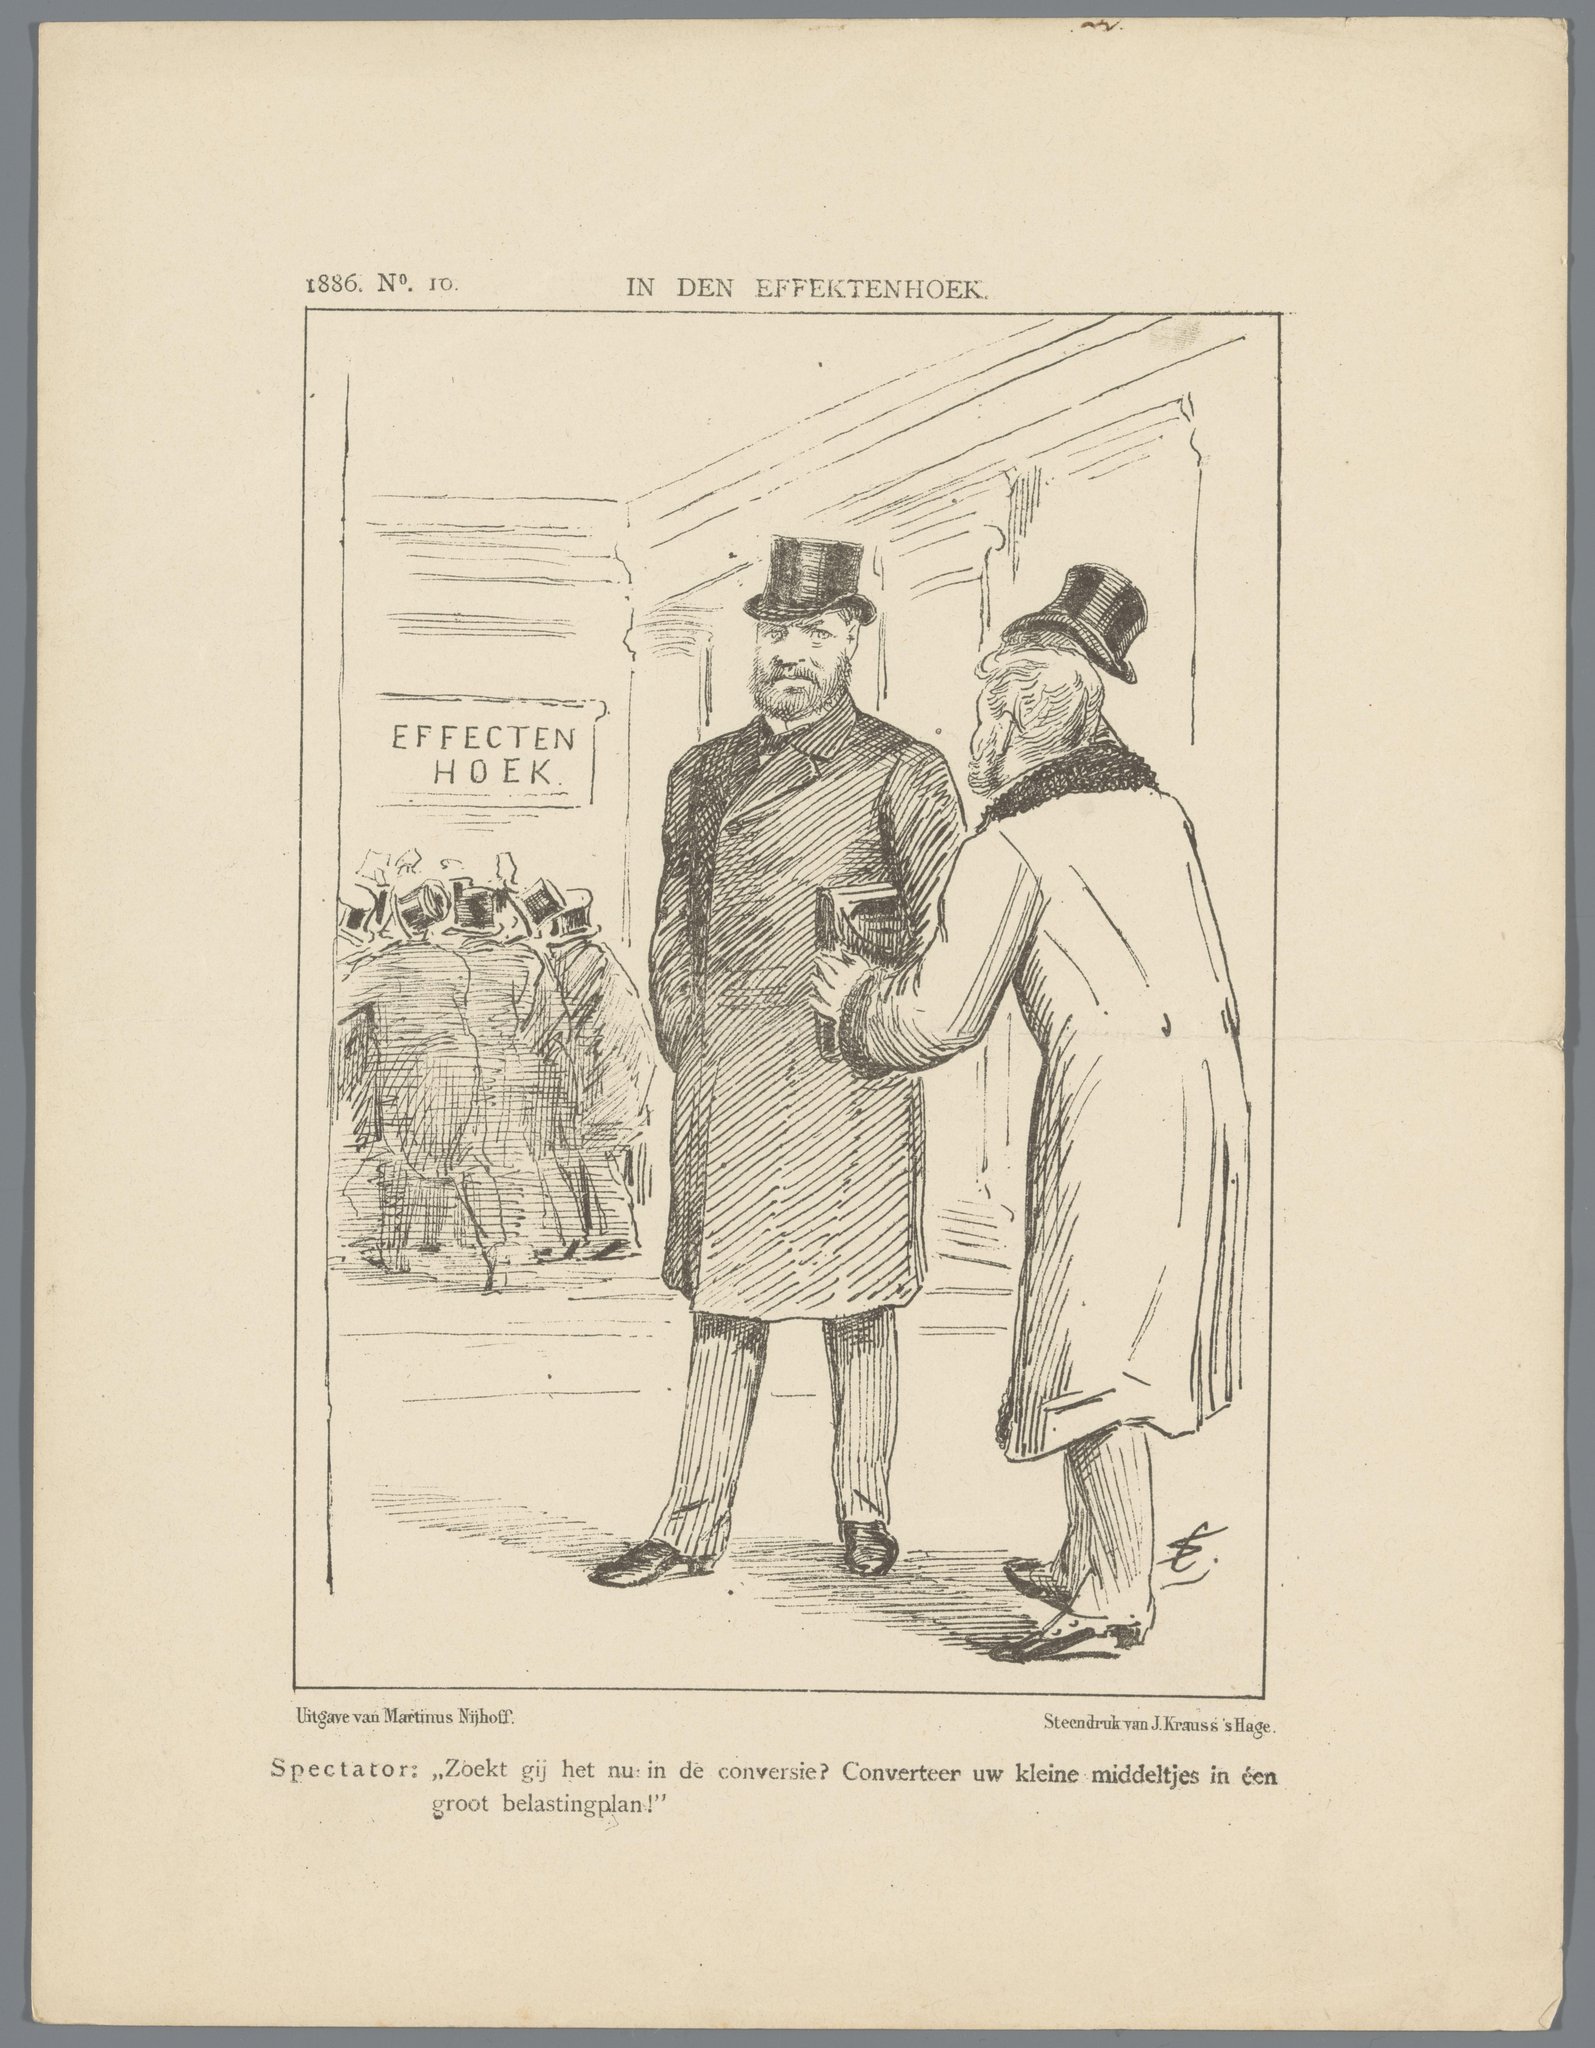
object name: cartoon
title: Politieke spotprent over financiën, 1886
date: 1886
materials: paper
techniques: lithograph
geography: the hague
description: Politieke spotprent over financiën, 1886. Plaat verschenen bij het weekblad De Nederlandsche Spectator, nr. 10, 1886.